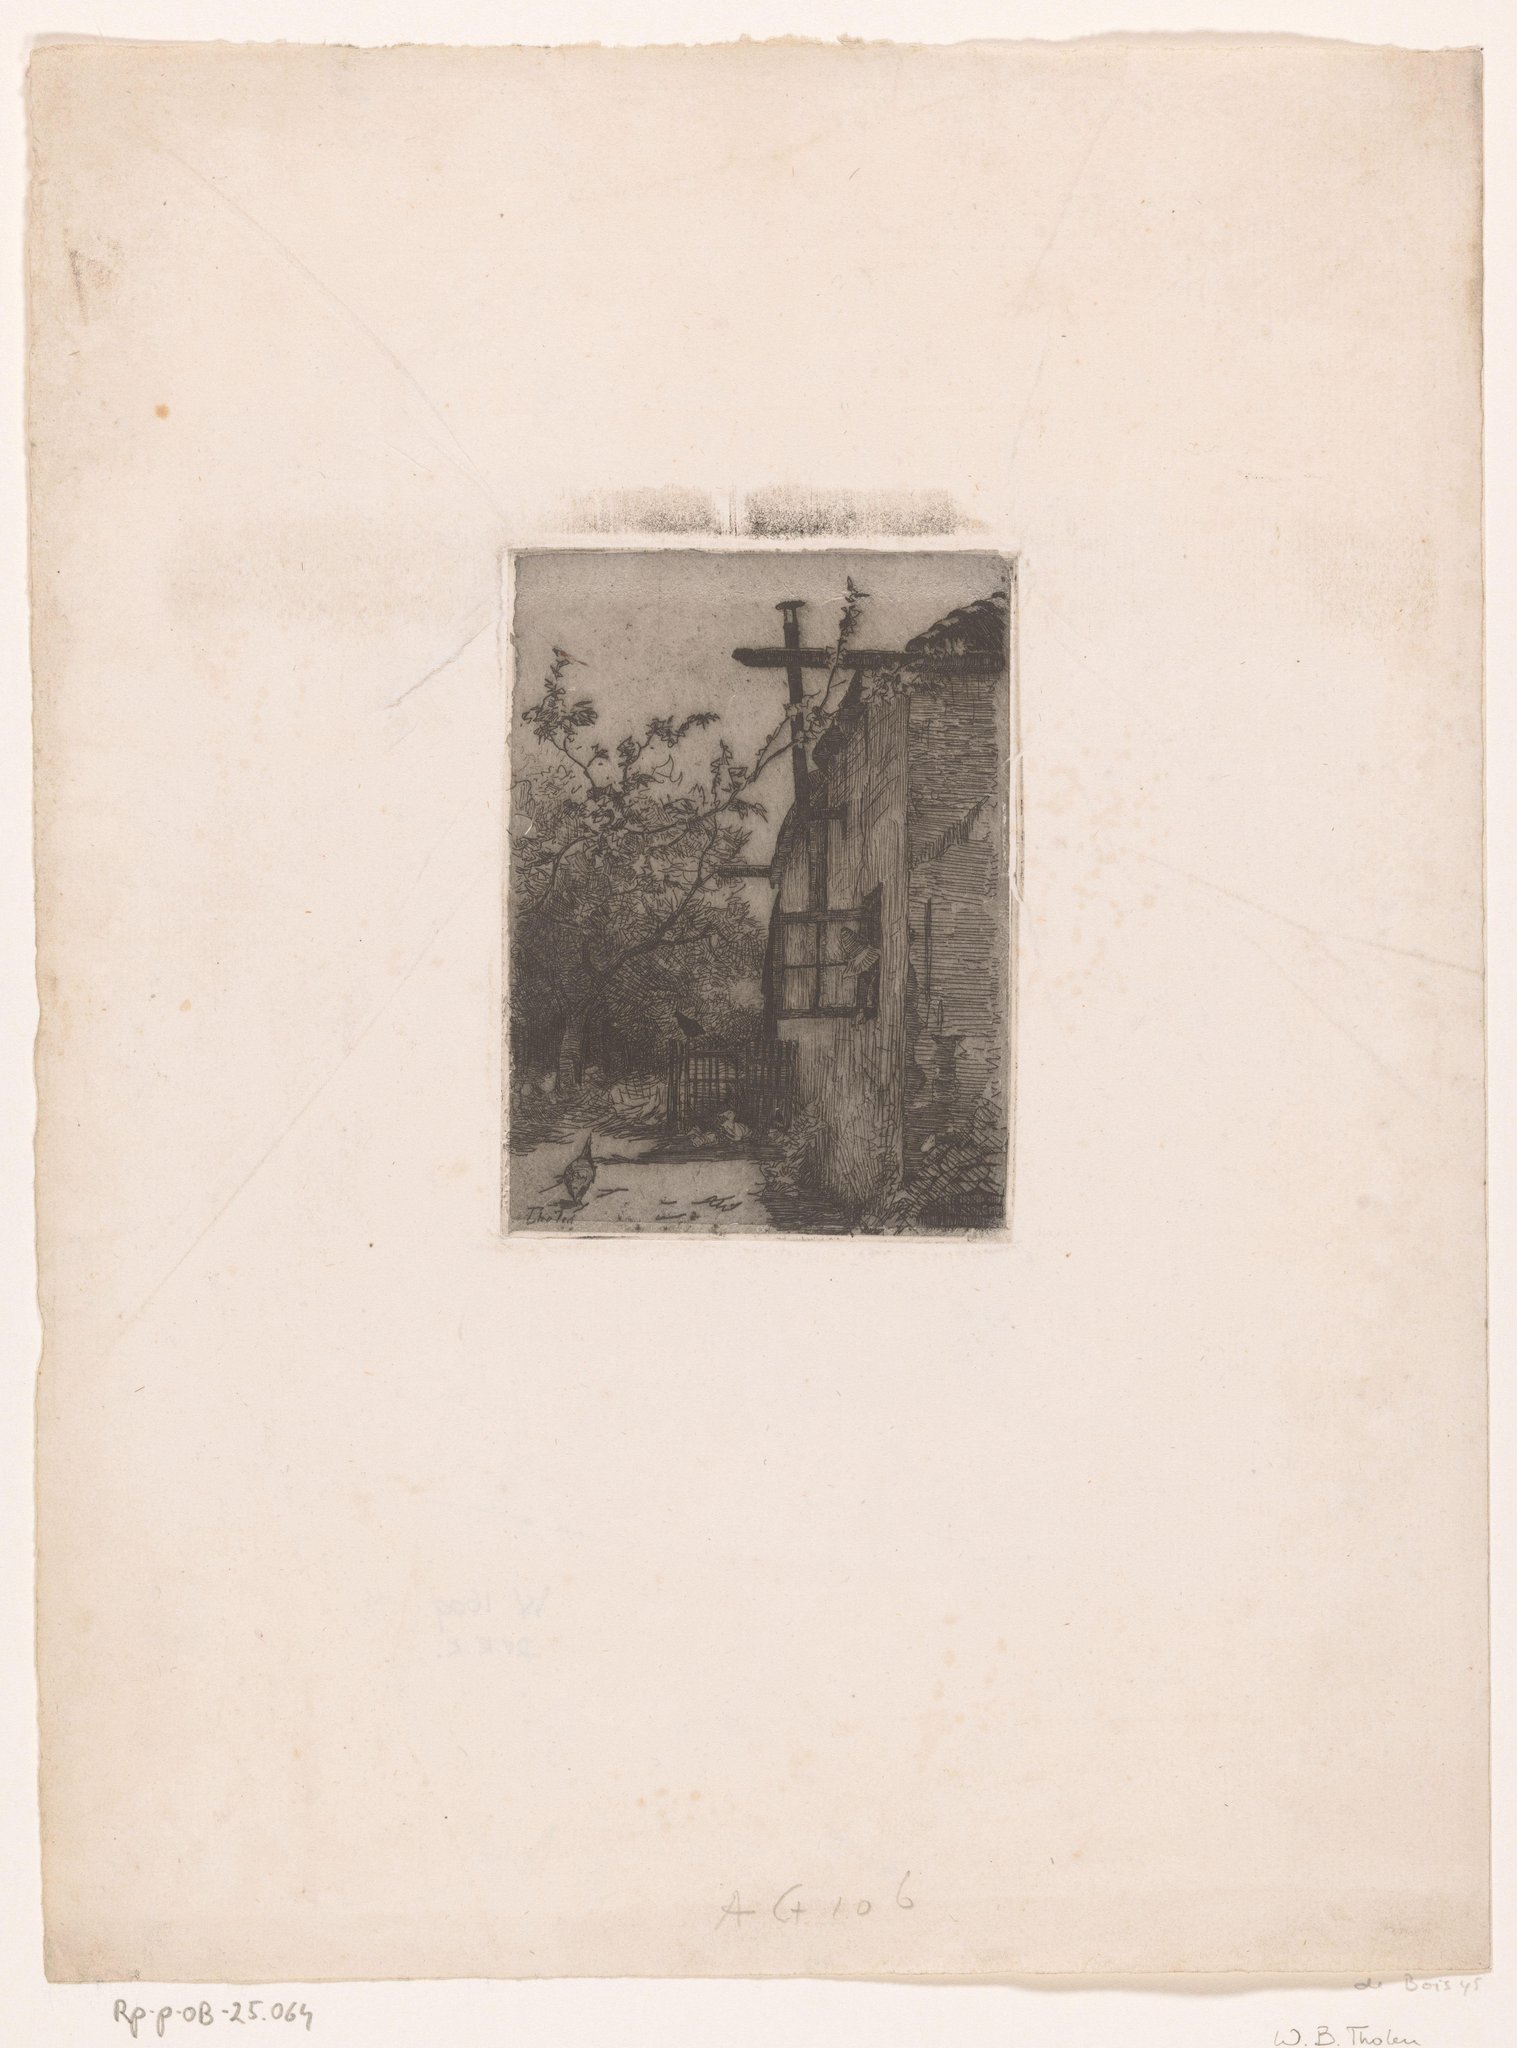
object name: print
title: Atelier, Ewijkshoeve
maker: willem bastiaan tholen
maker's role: draughtsman, painter, print maker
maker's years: 1860-1931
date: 1870-1931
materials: paper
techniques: etching, intaglio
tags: fowl (cock, hen, chicken, etc.), country-house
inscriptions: collector's mark: Lugt 2228